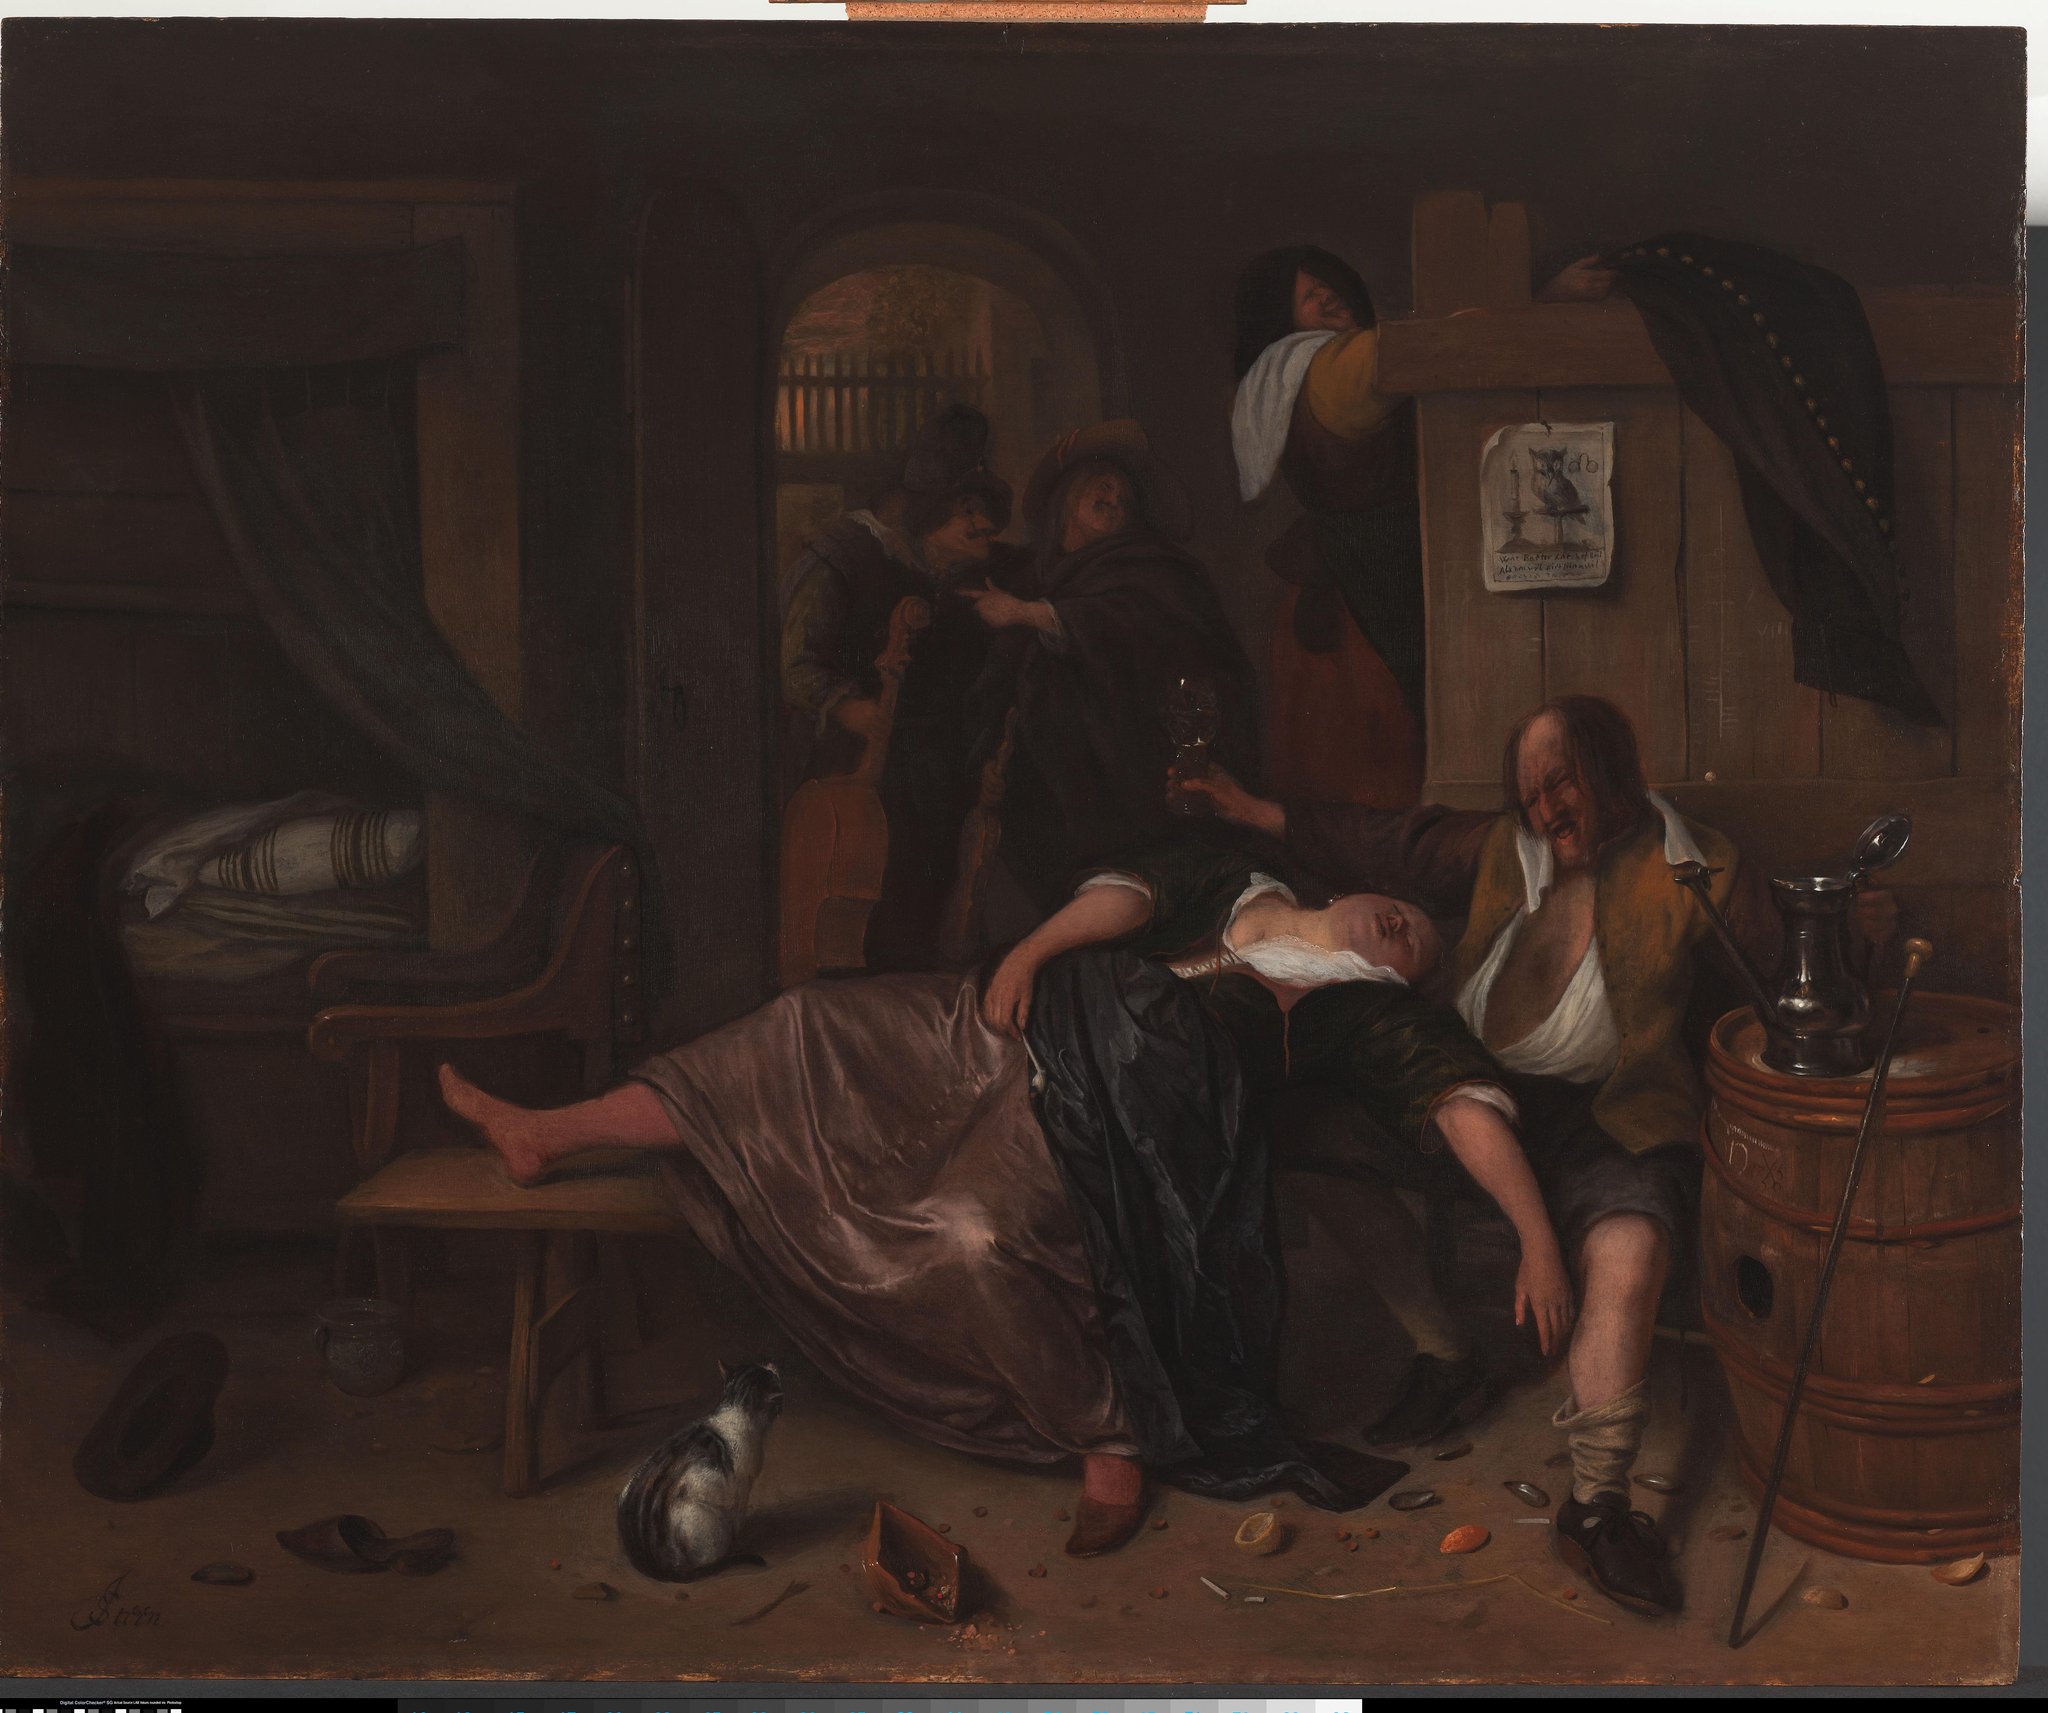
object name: painting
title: The Drunken Couple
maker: jan havicksz. steen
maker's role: painter, print maker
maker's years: 1625-1679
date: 1655-1665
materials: wood, oil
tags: blind, blindness - aa - metaphorically blind, owls, glass, rummer, theft, drunkenness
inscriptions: signature: ‘JSteen’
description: A man and woman are so drunk that they are unaware they are being robbed. Their foolishness is underscored by the print on the partition. It depicts an owl, considered a stupid creature in the 17th century. After all, it could not see by day, not even with a candle or eyeglasses. The drunken couple is thus just as blind as the owl, a message that survives in the English idiom ‘blind as a bat’.